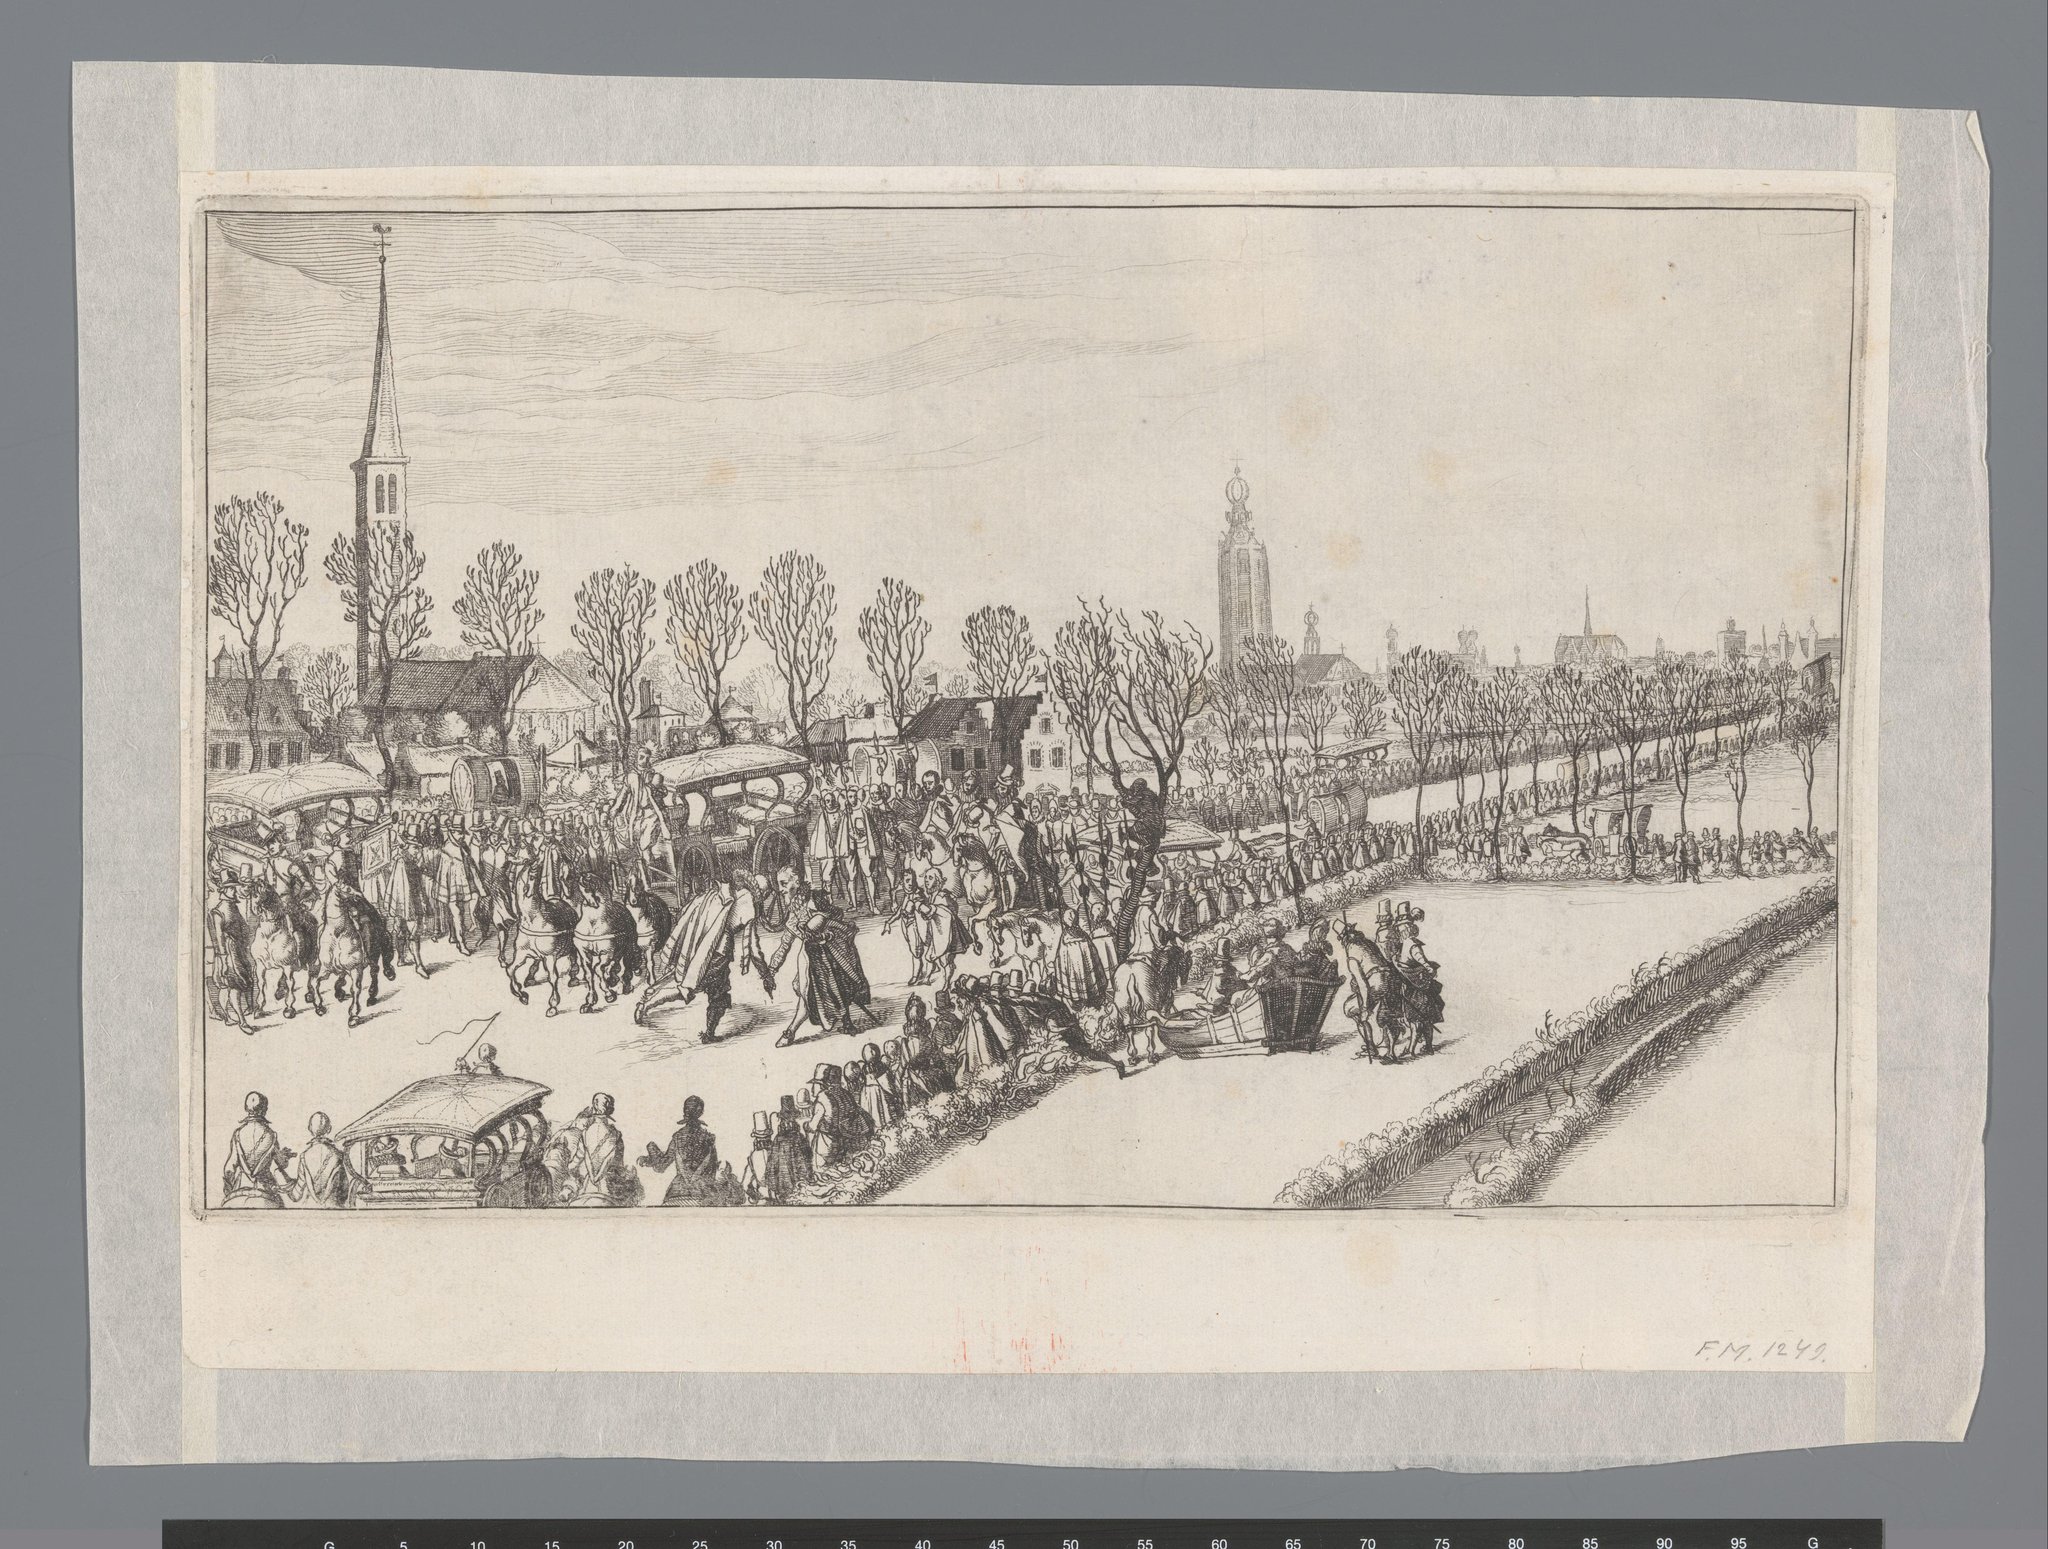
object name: print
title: Aankomst van de vijf Spaanse ambassadeurs te Rijswijk, februari 1608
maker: simon frisius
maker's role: print maker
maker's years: 1570-1628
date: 1608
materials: paper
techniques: etching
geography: northern netherlands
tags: maurice (prince of orange), peace negotiations, meeting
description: Aankomst van de vijf Spaanse ambassadeurs te Rijswijk voor de vredesonderhandelingen te Den Haag, februari 1608. Maurits en Spinola geven elkaar de hand. De ambassadeurs worden begroet bij een laan met aan weerszijden rijen toeschouwers. Rechts enkele mensen in een slede.